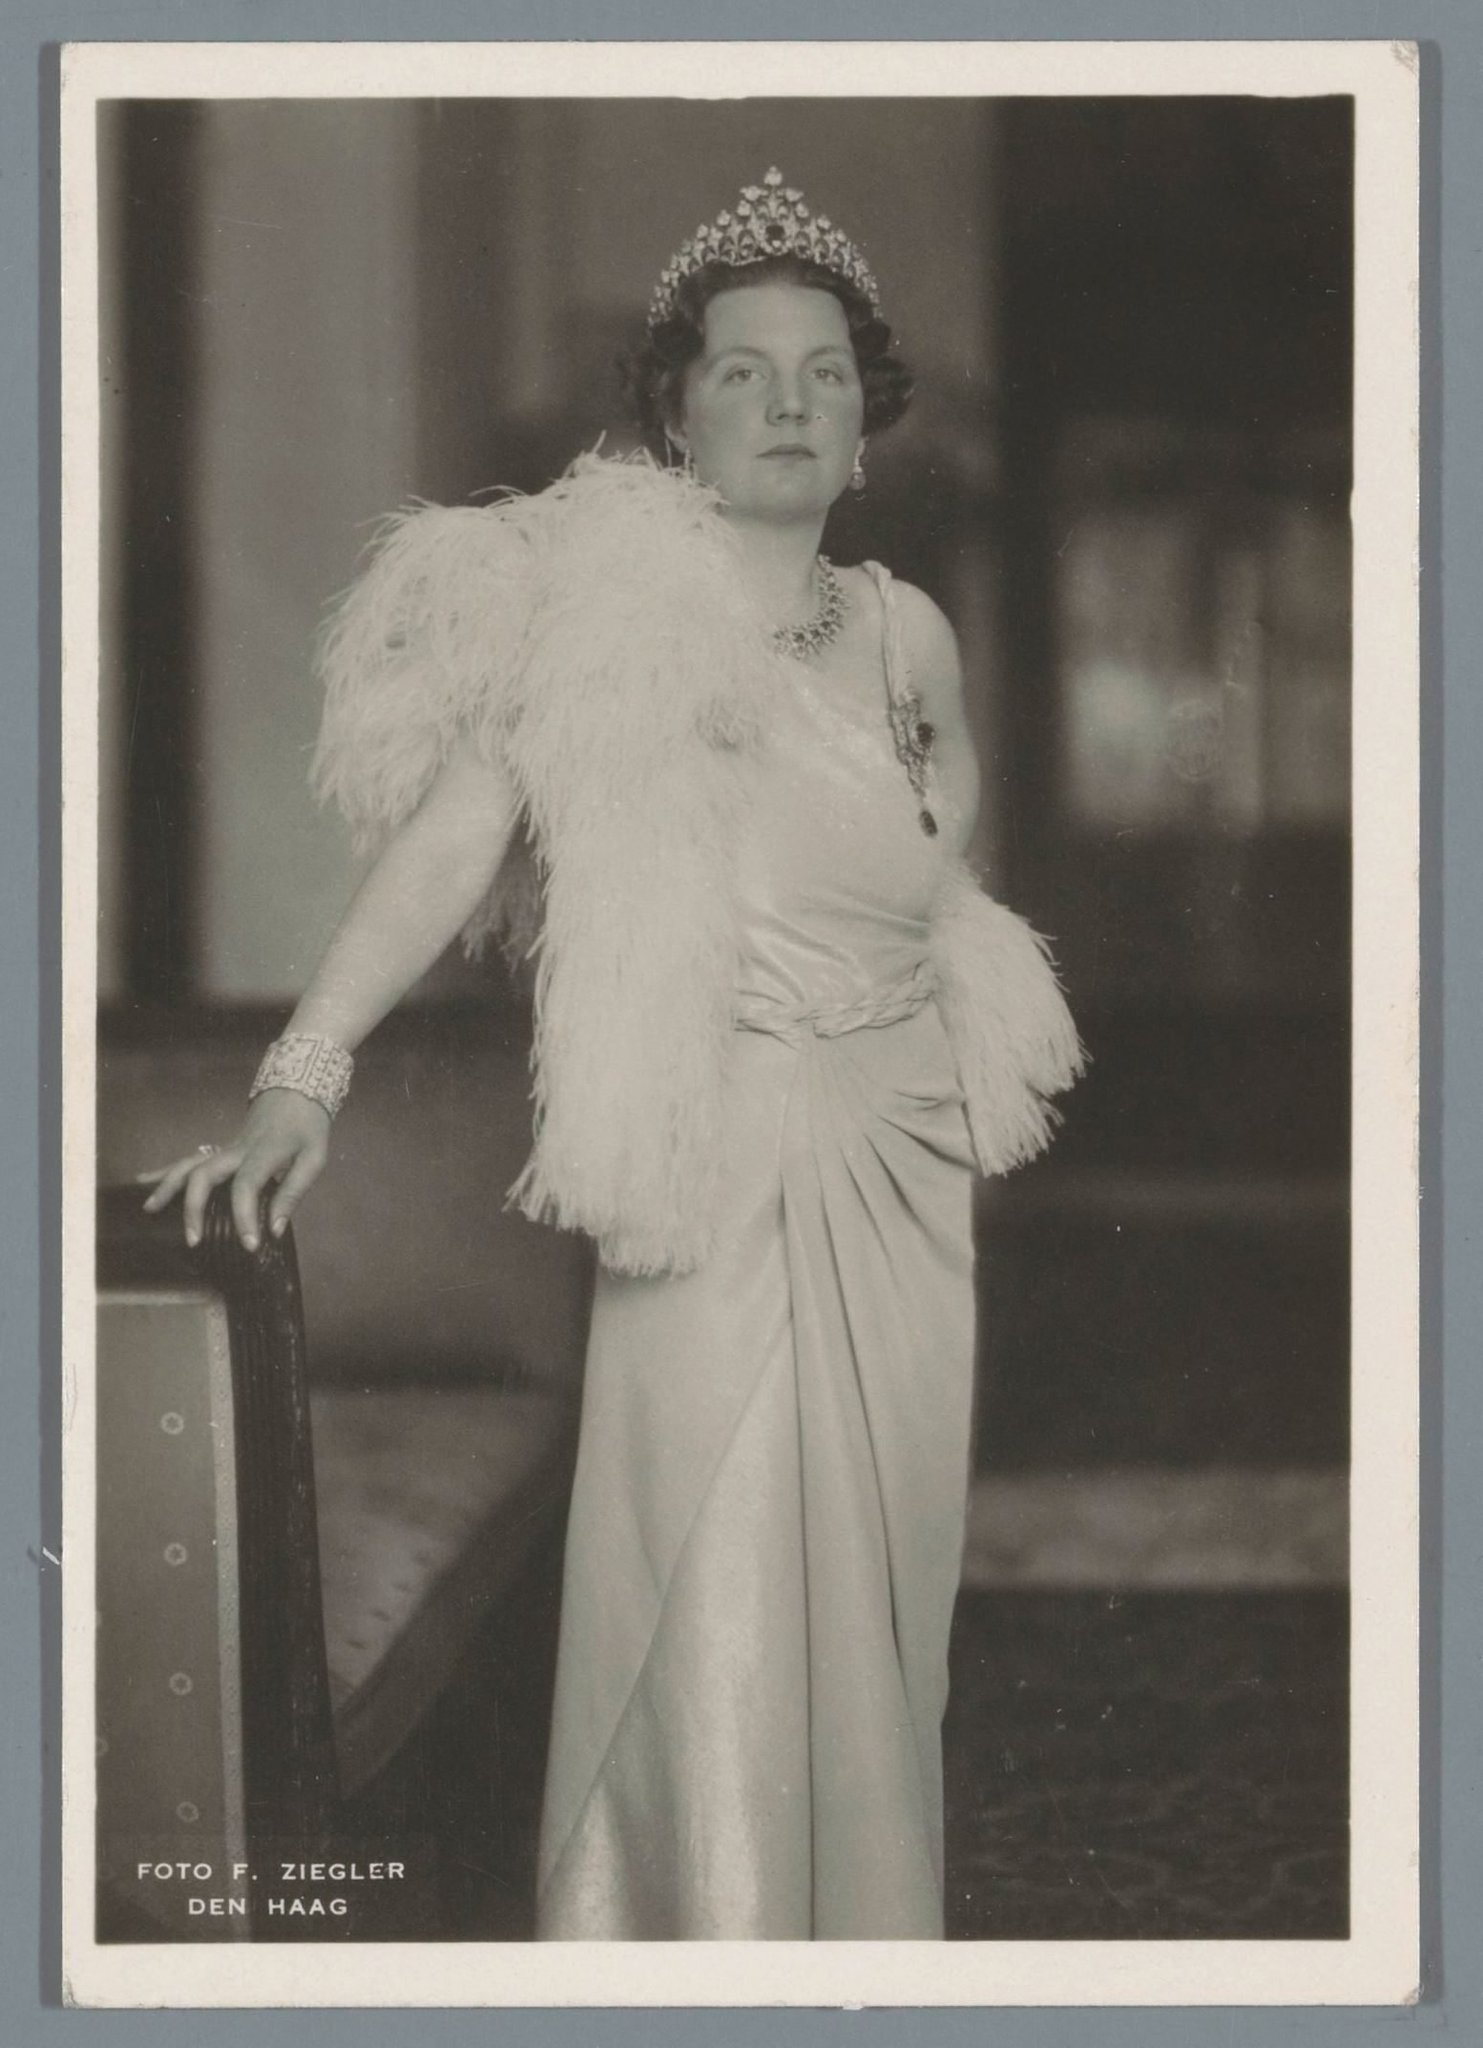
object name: photograph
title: Portret van prinses Juliana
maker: franz ziegler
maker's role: fotograaf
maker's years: 1893-1939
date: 1937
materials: photographic support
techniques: gelatin silver print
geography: the hague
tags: juliana of the netherlands, crown princess, historical persons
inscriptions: number: ‘60.’, inscription: ‘D. Drost & Zoon/ Koffie - Thee/ AMSTERDAM/ AMSTEL 306/ Telefoon 37114/ Opgericht Ao, 1829’